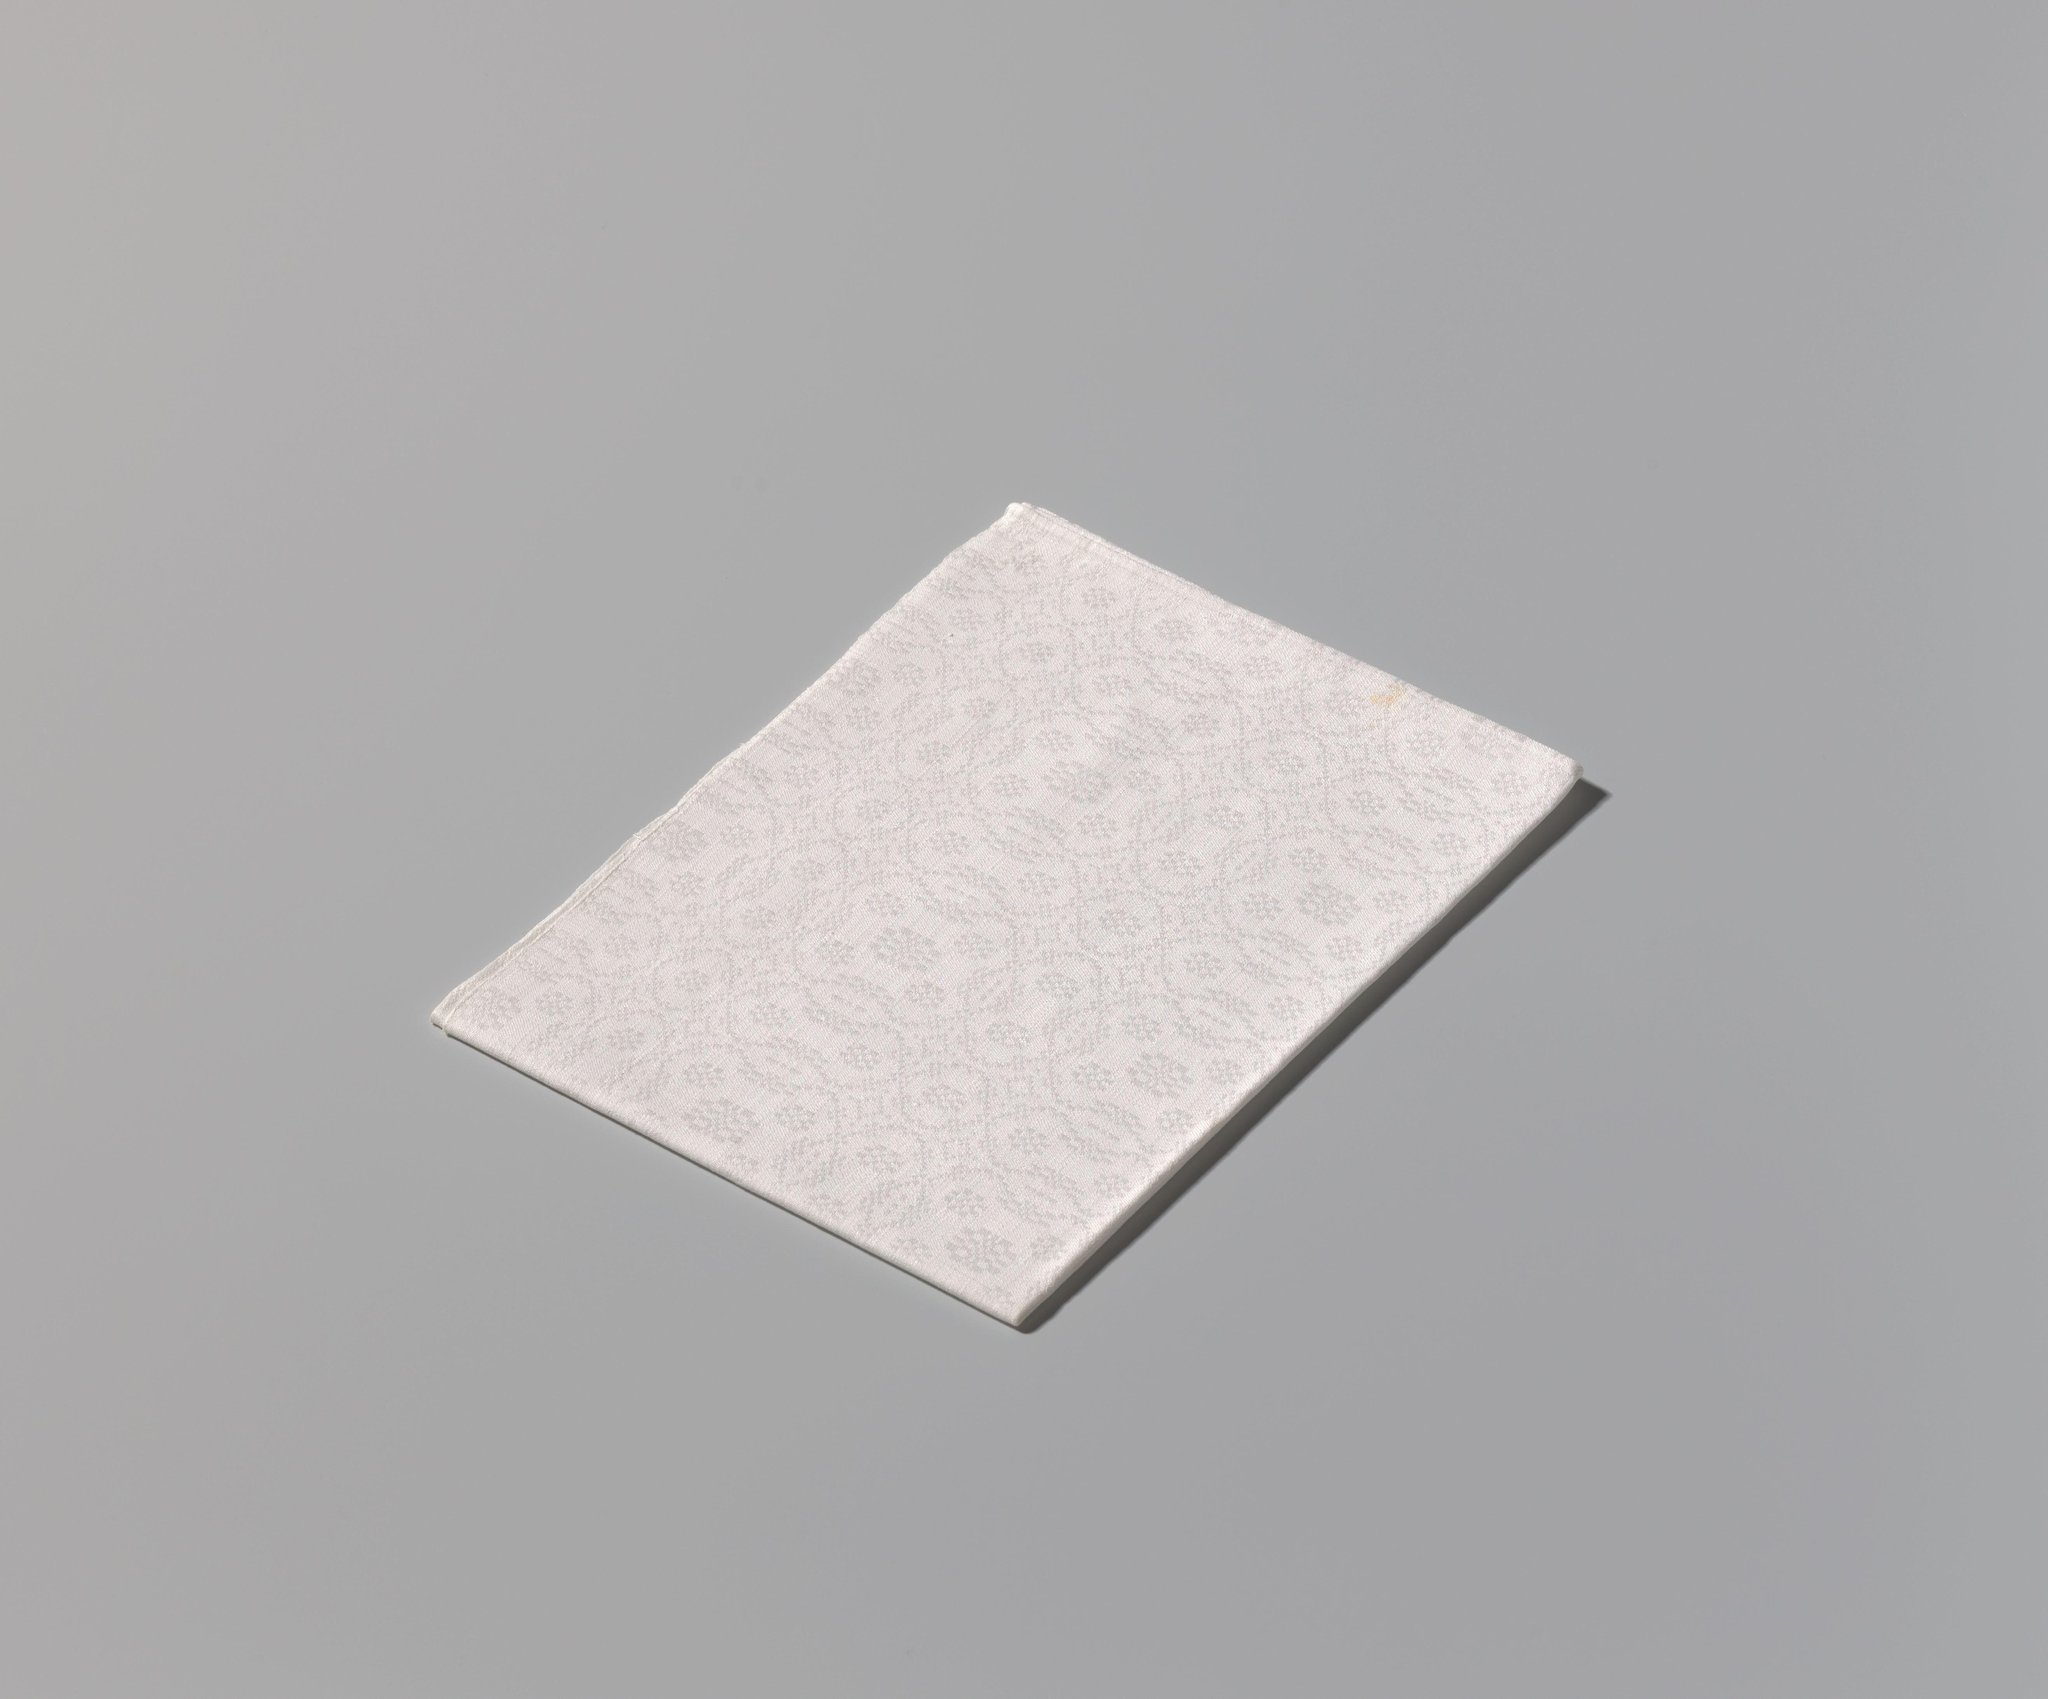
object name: napkin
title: Servet van pellendamast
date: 1699-1749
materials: linen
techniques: weave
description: Servet van pellendamast. Rijen van elkaar oversnijdende cirkels en ovalen zijn verticaal en horizontaal gesteld. Tussen liggende kleinere cirkels. Vulling van blokken: de grote cirkels met vijf, de ovalen met twee en de kleinere cirkels met een. Het servet hoort bij tien servetten en een tafellaken (BK-16823-A t/m BK-16823-L). Het servet is gehalveerd.